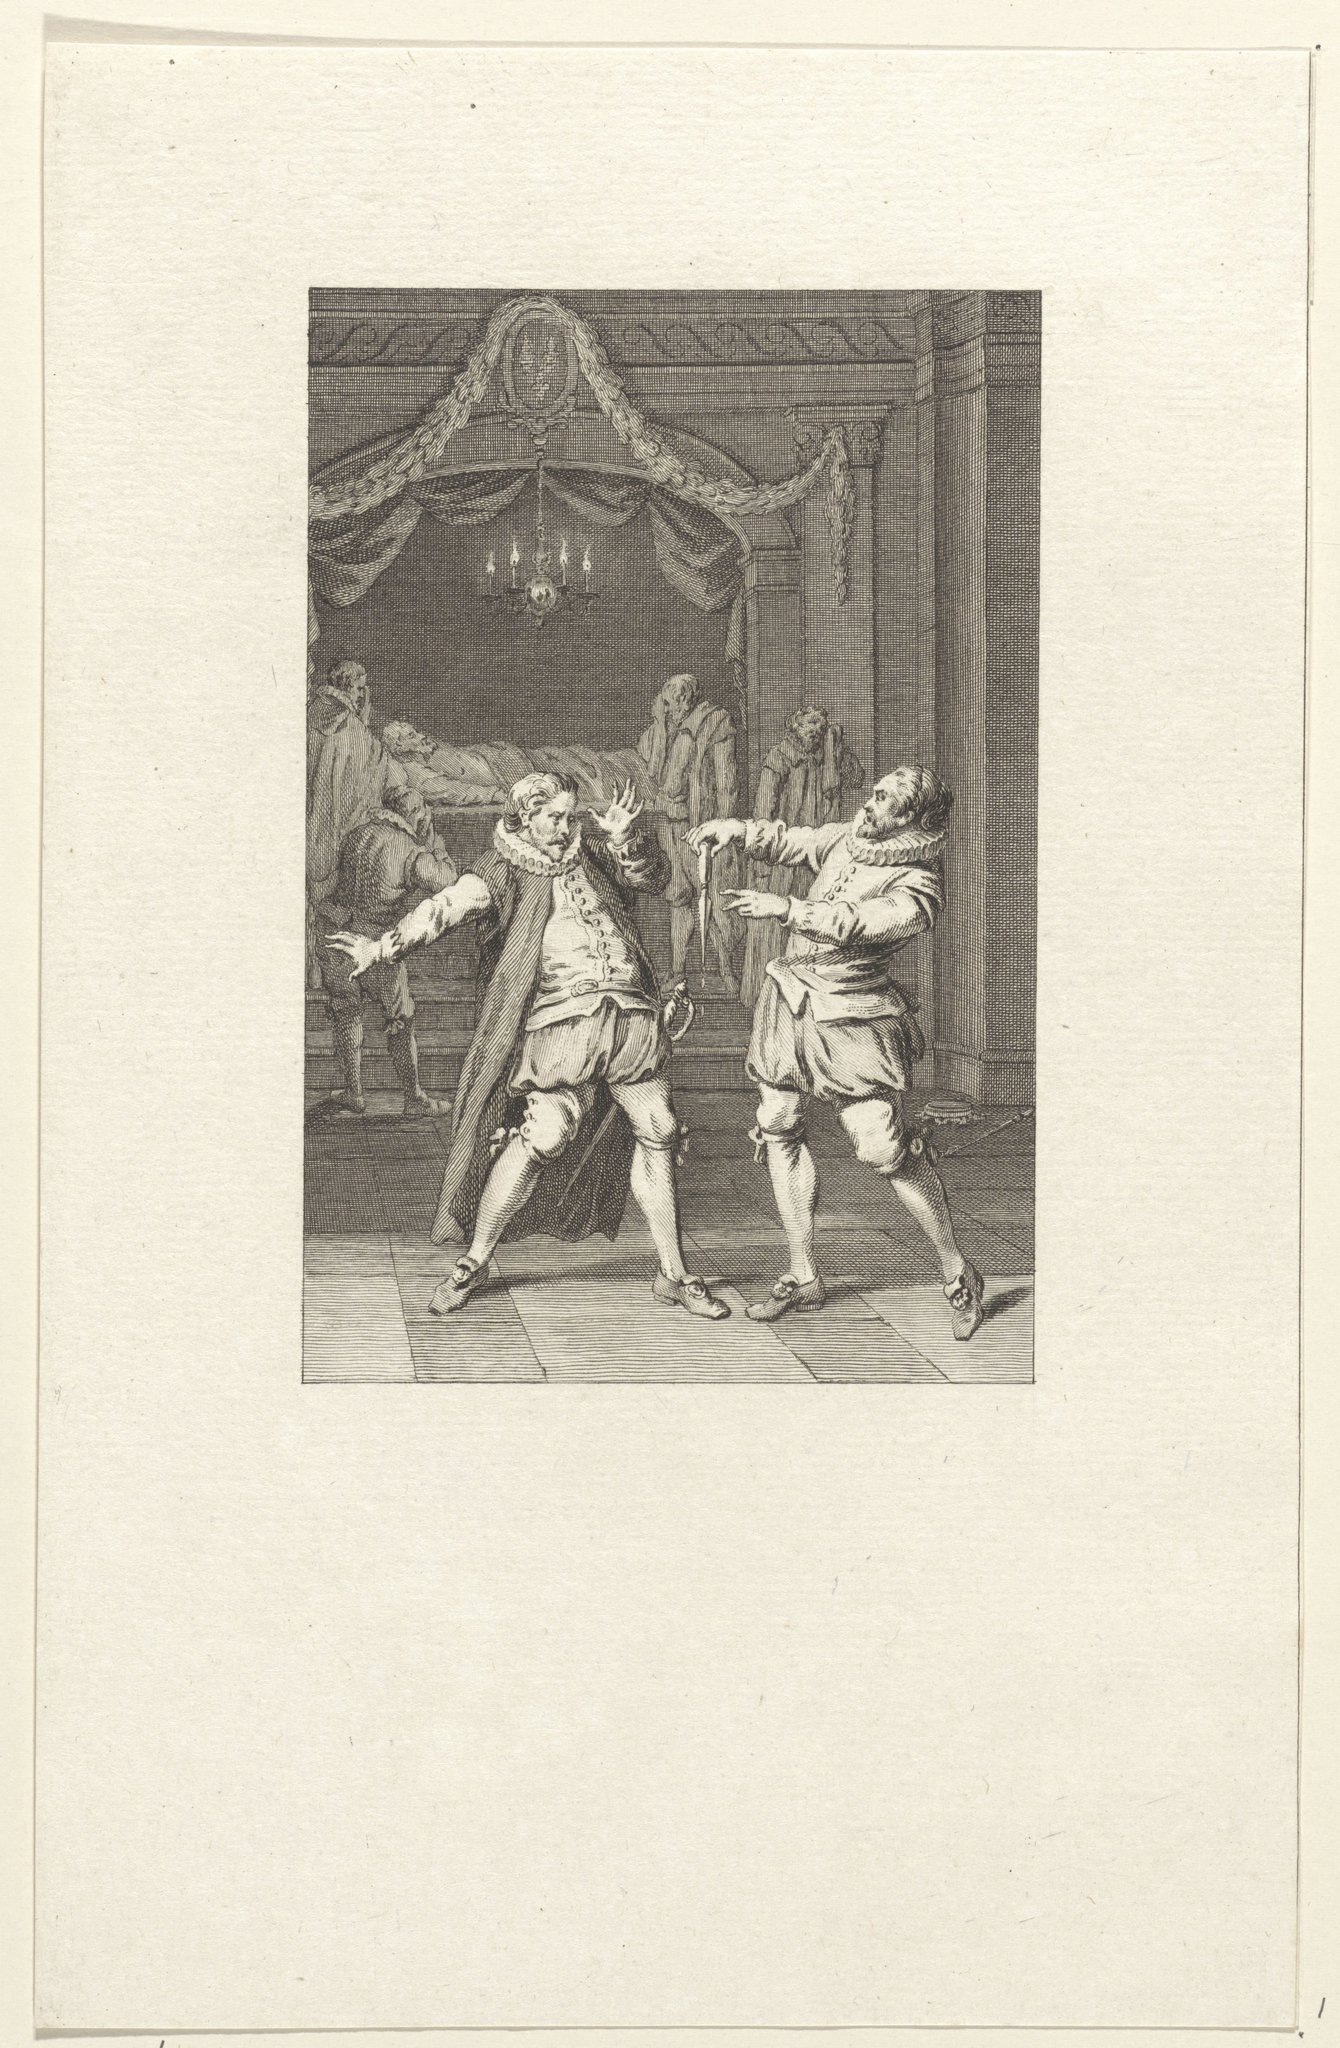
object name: print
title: Hertog van Sully bij het lijk van Hendrik IV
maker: reinier vinkeles (i)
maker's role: draughtsman, print maker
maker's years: 1741-1816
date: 1785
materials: paper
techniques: engraving, etching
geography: amsterdam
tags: maximilien de béthune (duke of sully), hendrik iv (koning van frankrijk en navarra), vigils and wakes ~ burial rites, violent death by dagger, knife (+ variant), attempt, political murder, paris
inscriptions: collector's mark: Lugt 240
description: Later staat prent gebruikt als boekillustratie in: Martinet, Joannes Florentius. Historie der waereld. Amsterdam: Johannes Allart, 1780-1788. 25 delen. deel VI, pl. IV.